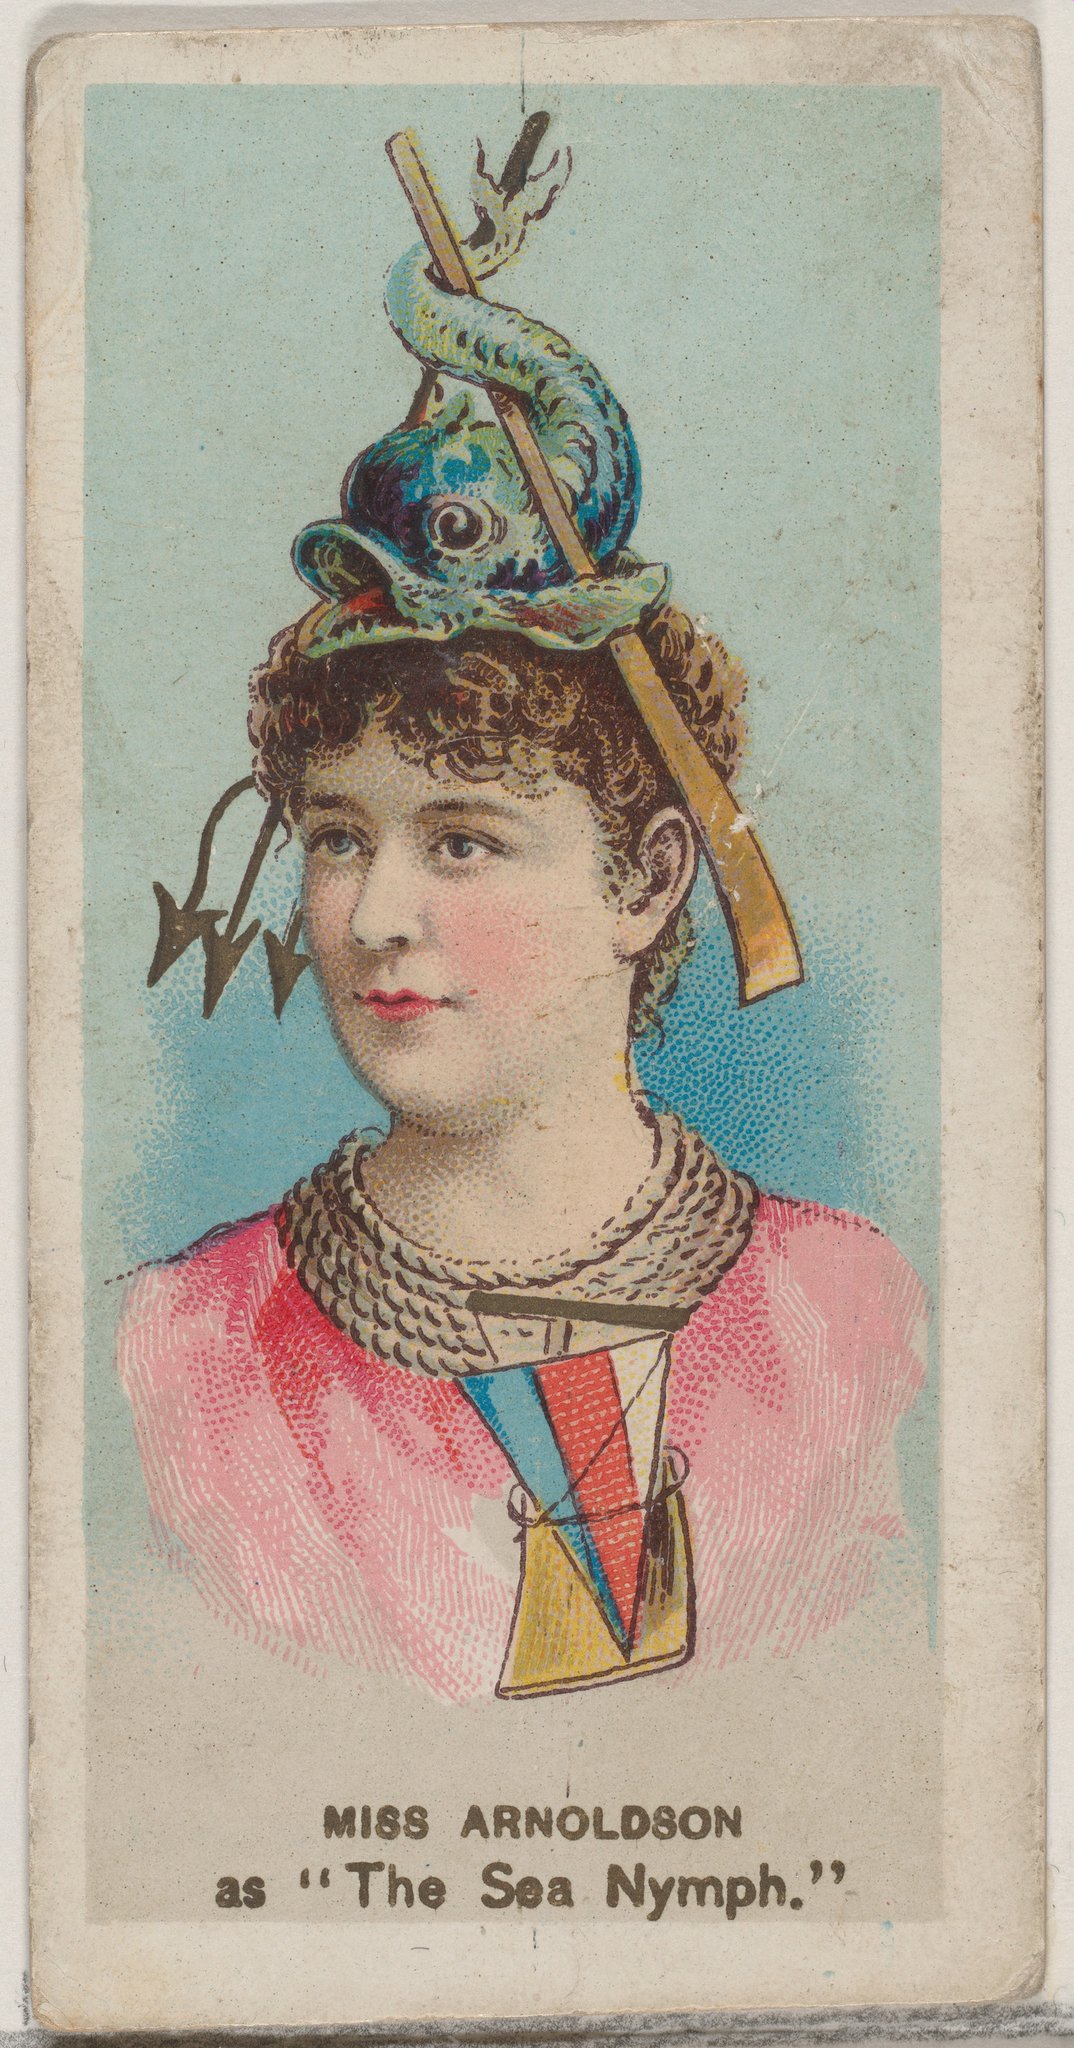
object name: print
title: Miss Arnoldson as "The Sea Nymph," from the series Fancy Dress Ball Costumes (N73) for Duke brand cigarettes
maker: w. duke, sons & co.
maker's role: publisher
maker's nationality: american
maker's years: 1870-1920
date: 1889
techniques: color lithograph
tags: women,fish,actresses